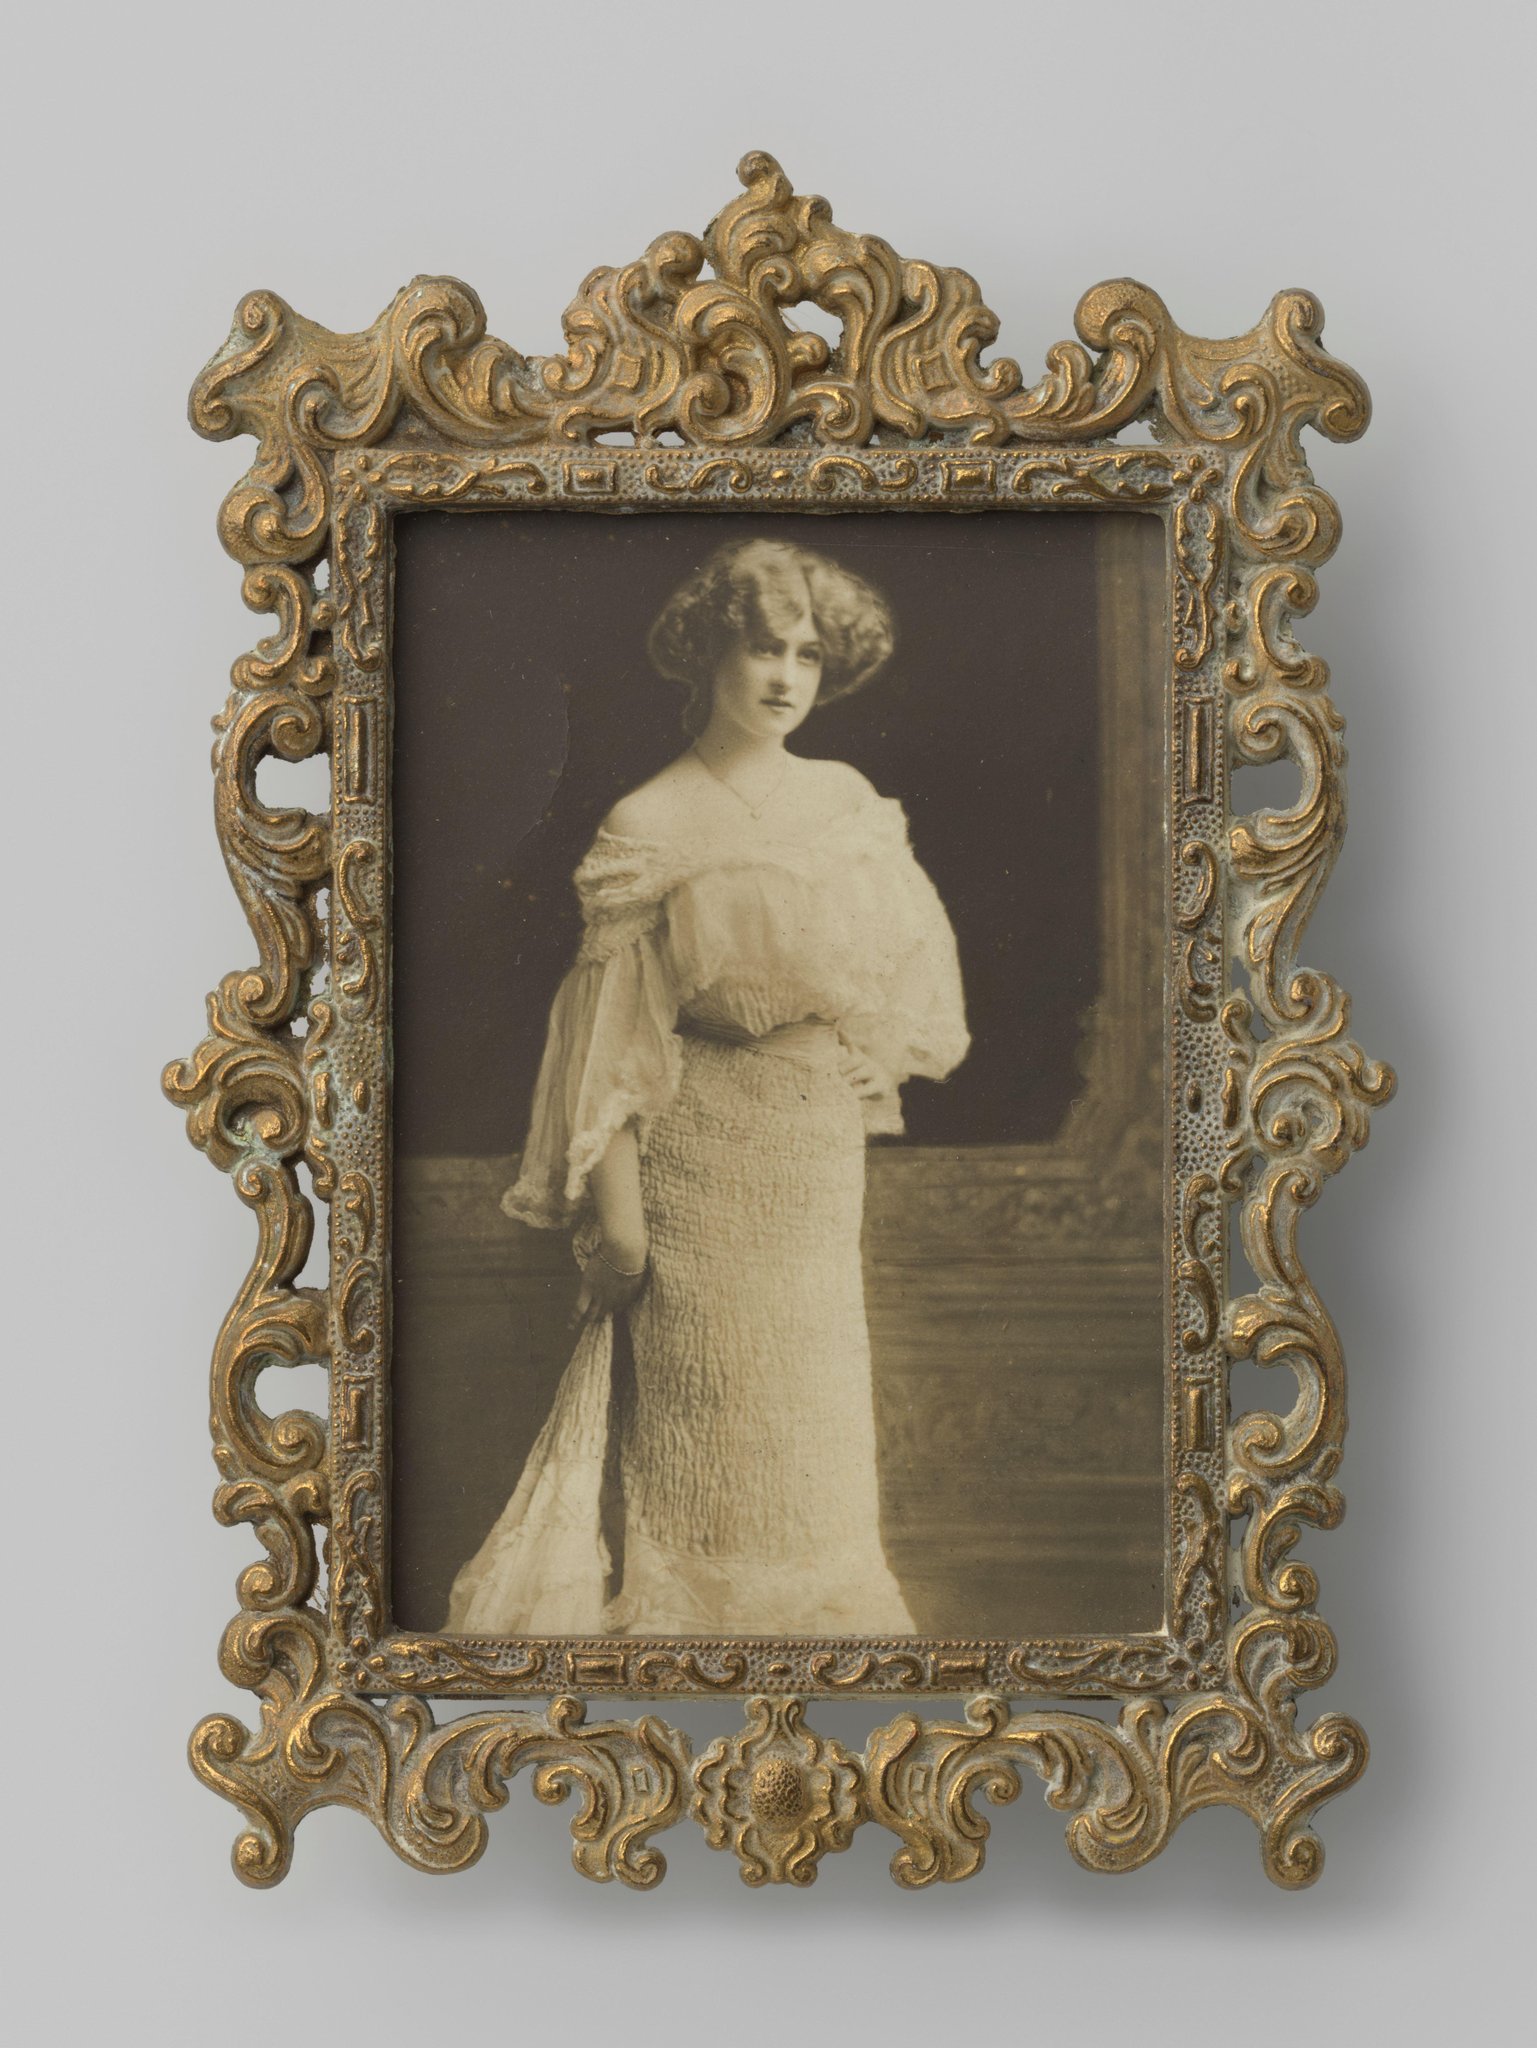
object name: frame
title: Portret van een onbekende vrouw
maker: Anonymous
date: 1890-1910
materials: paper, glass, metal, wood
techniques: gelatin silver print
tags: adult woman, anonymous historical person portrayed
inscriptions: inscription: ‘DEPOSÉ MADE IN ITALY’